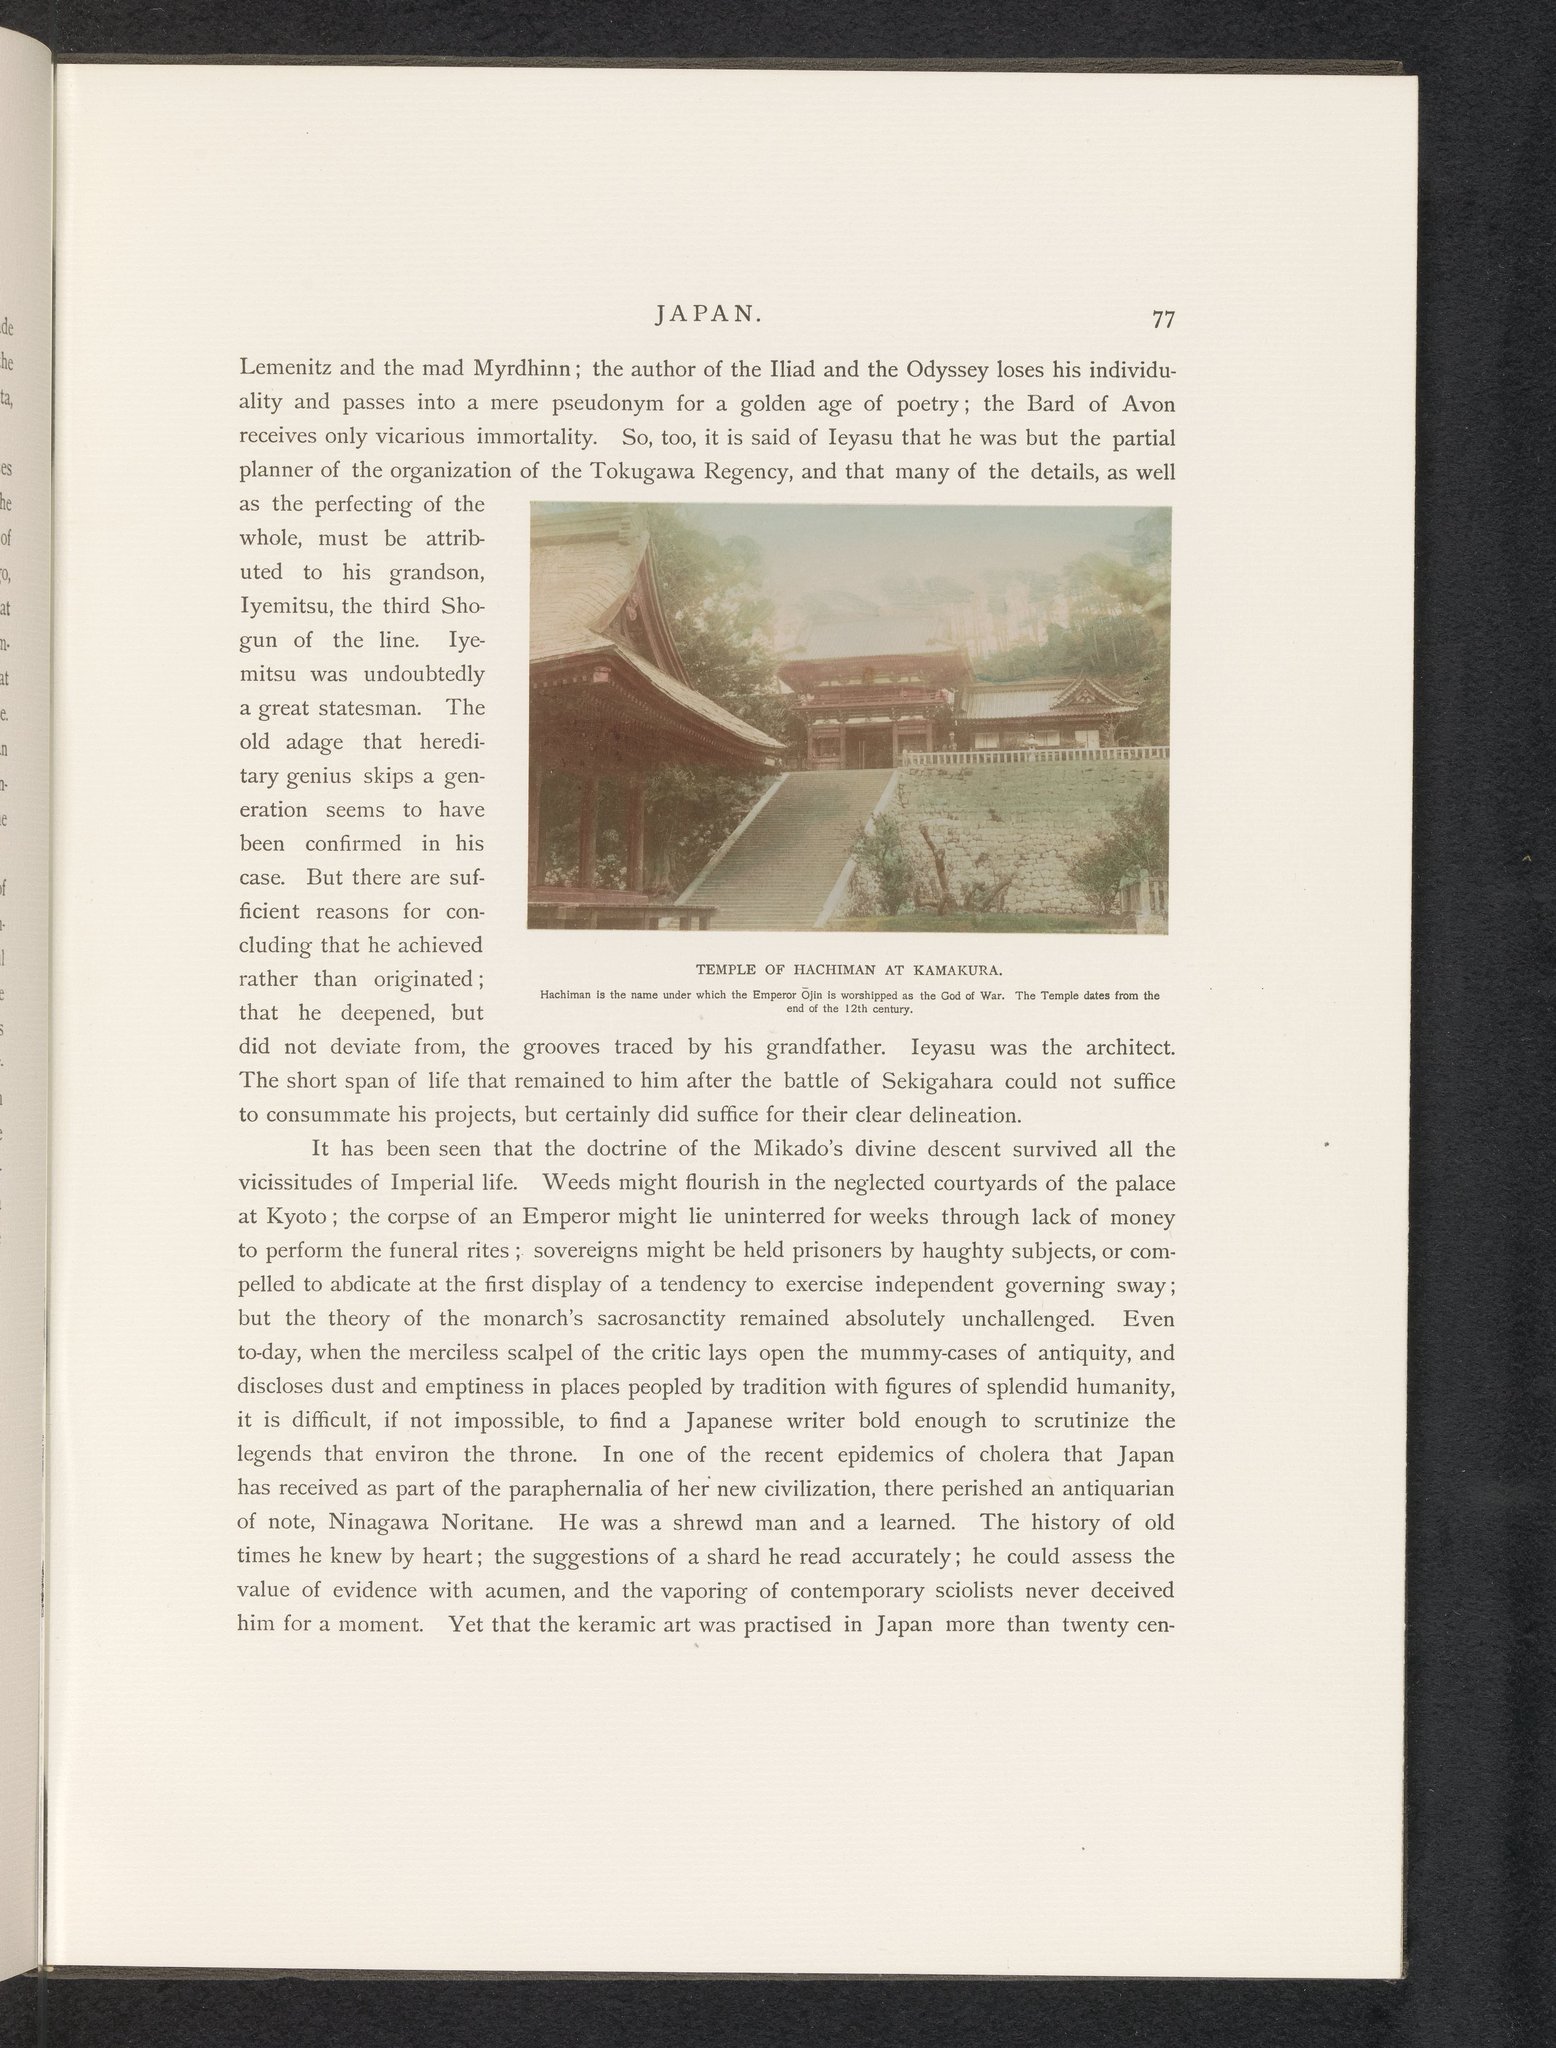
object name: page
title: Temple of Hachiman at Kamakura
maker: Anonymous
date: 1887-1897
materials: photographic support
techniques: albumen print, hand coloring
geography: japan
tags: temple, shrine ~ non-christian religions, façade (of house or building)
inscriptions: inscription: ‘Hachiman is the name under which (...) The Temple dates from the end of the 12th century.’